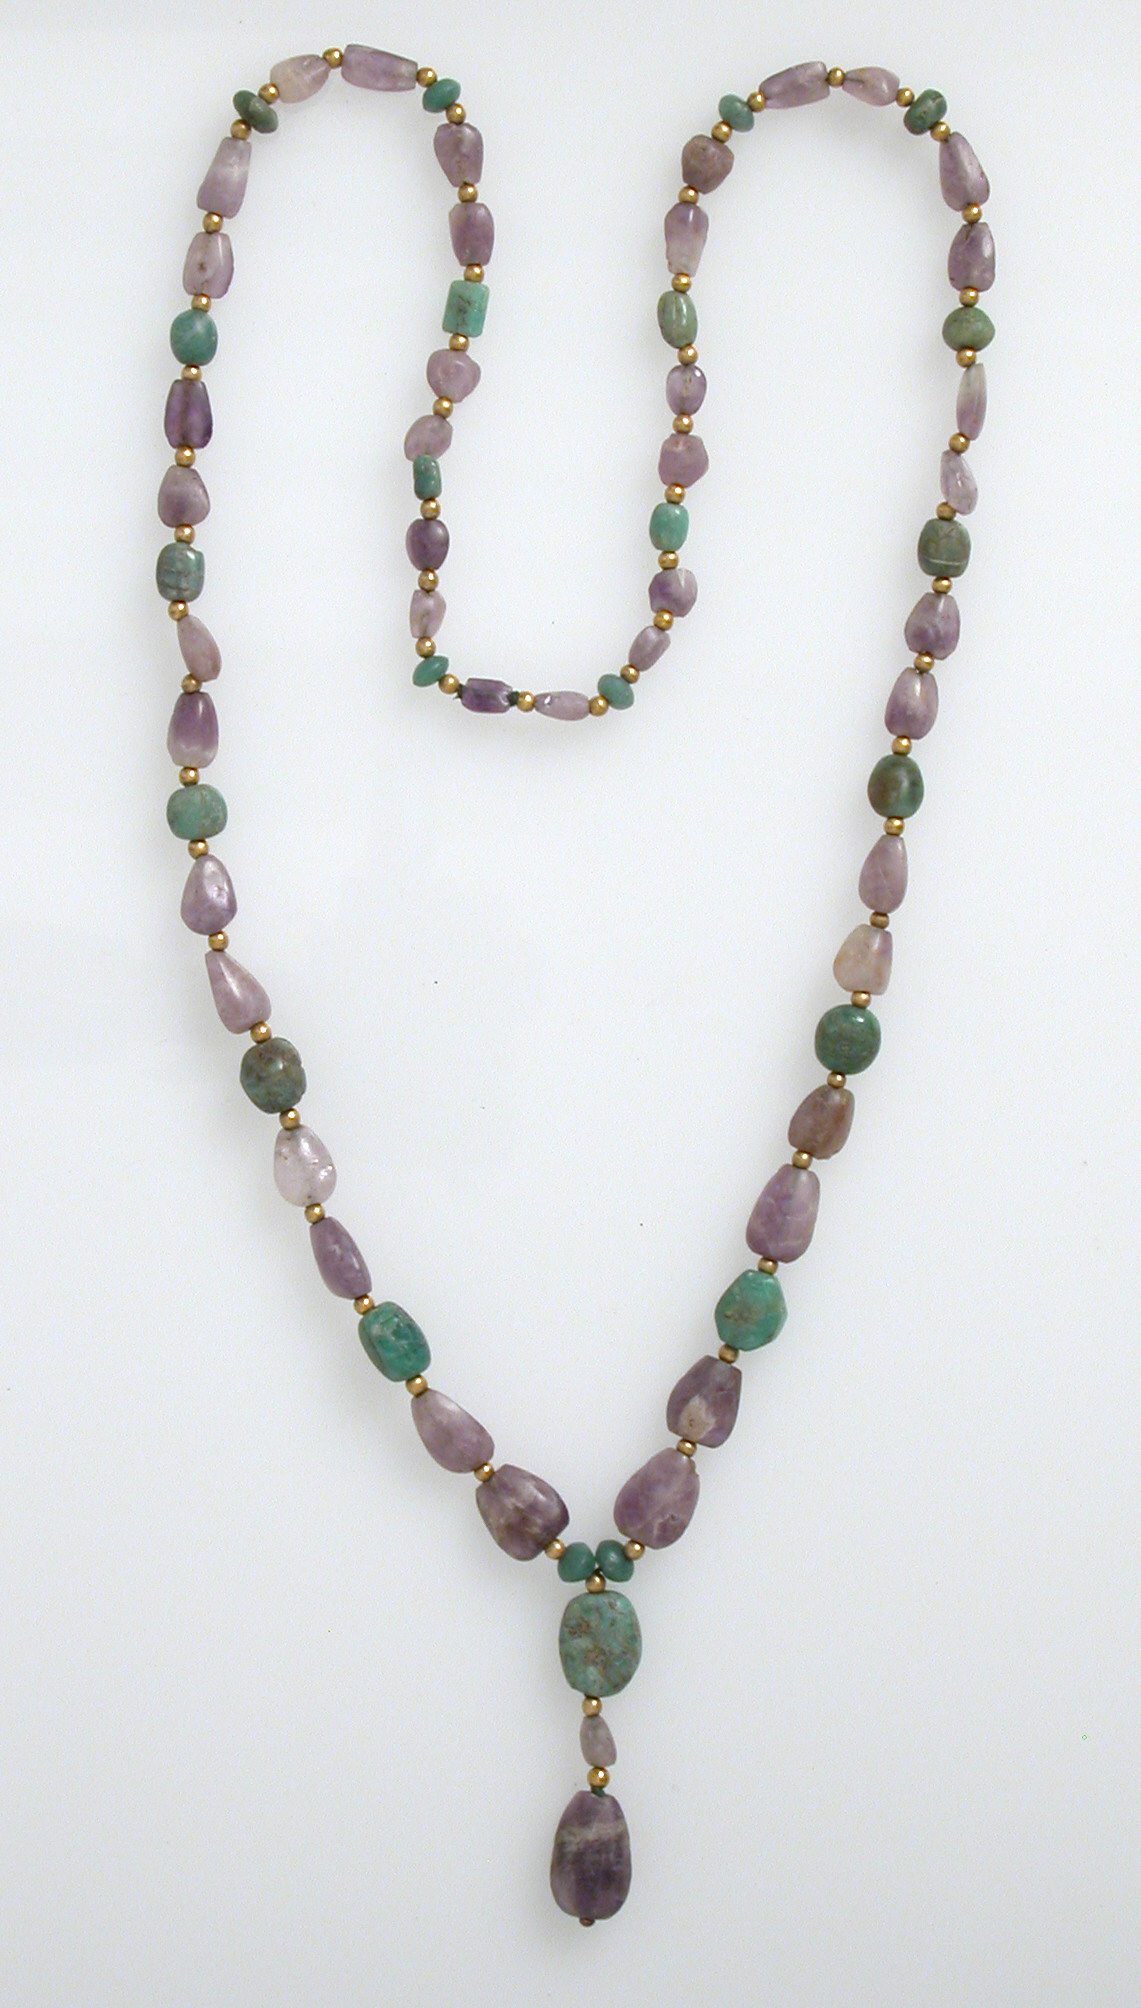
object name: necklace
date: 201-1200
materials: gemstone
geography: egypt